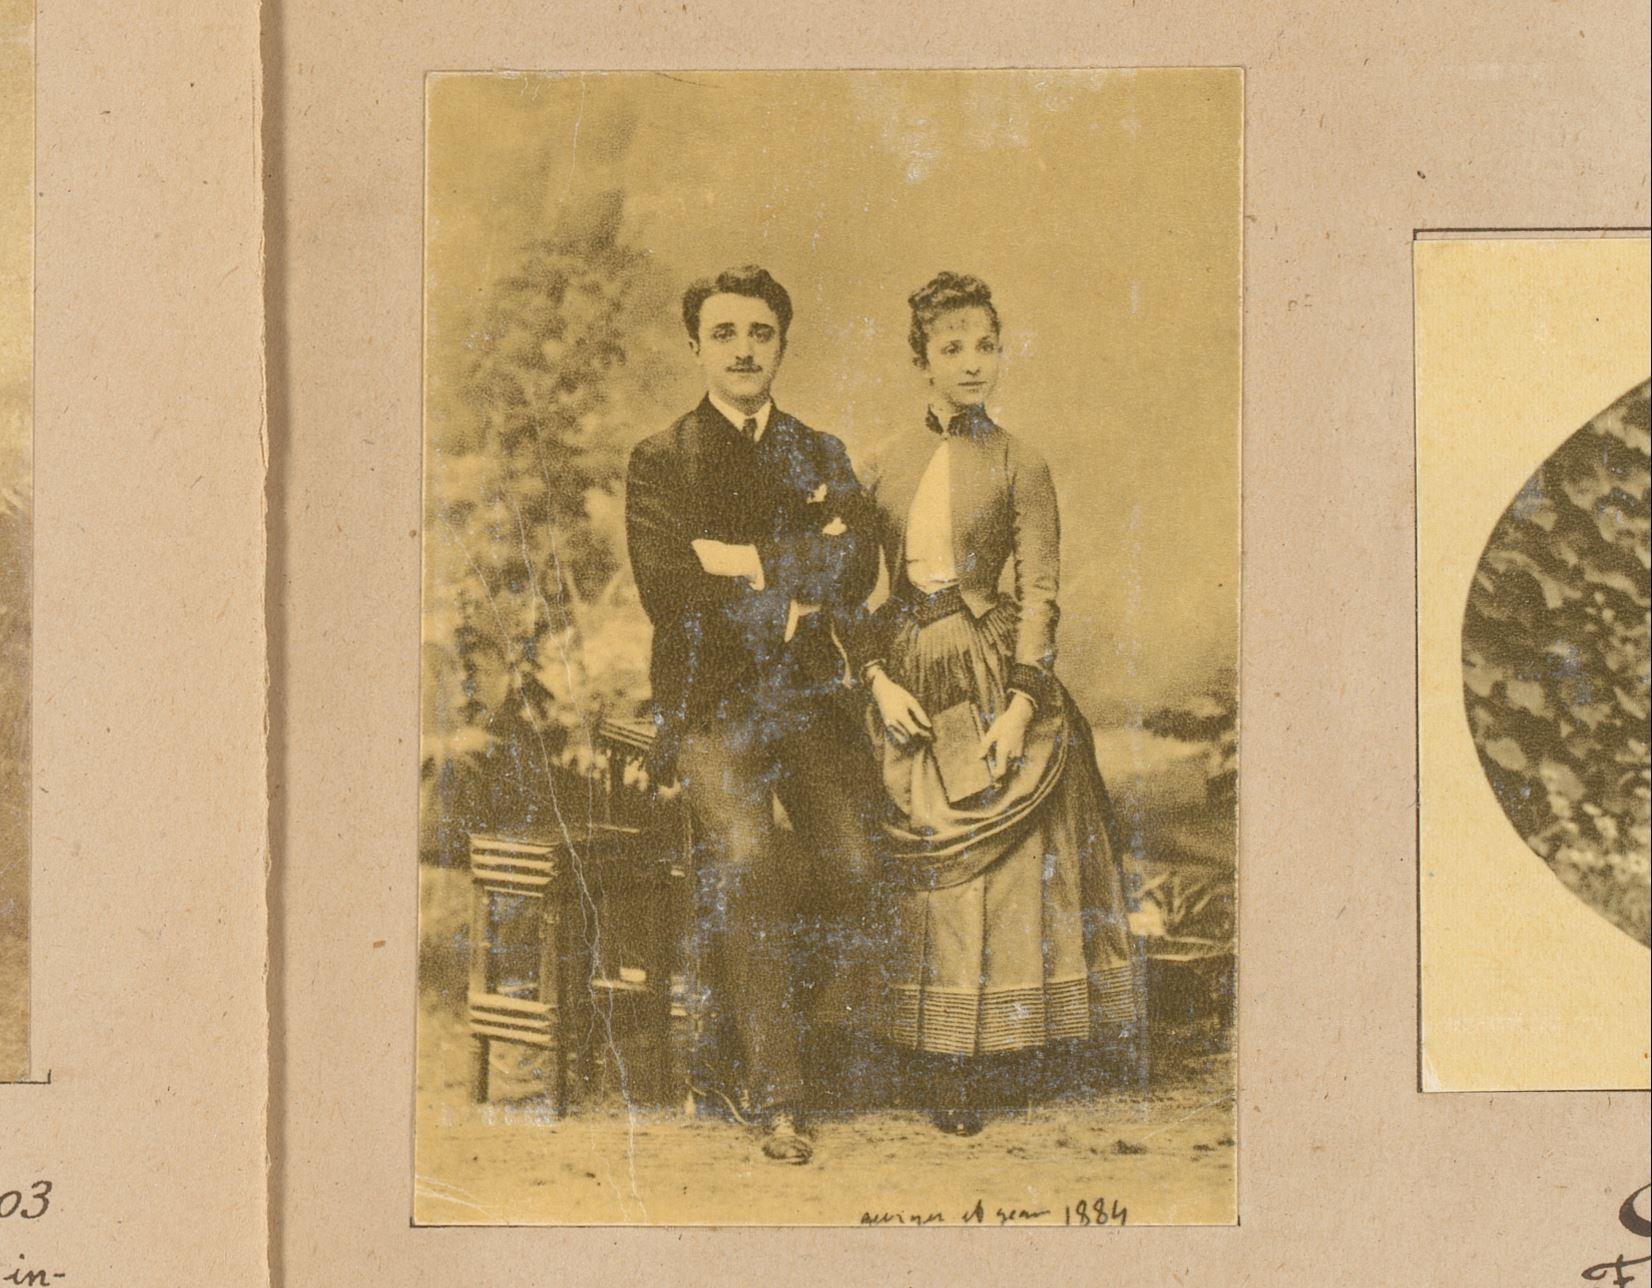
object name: photograph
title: Georges et Jeanne Hugo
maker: Anonymous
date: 1884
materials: paper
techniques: rotogravure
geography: france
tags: brussels, paris, grandchildren (second degree family relationships), france